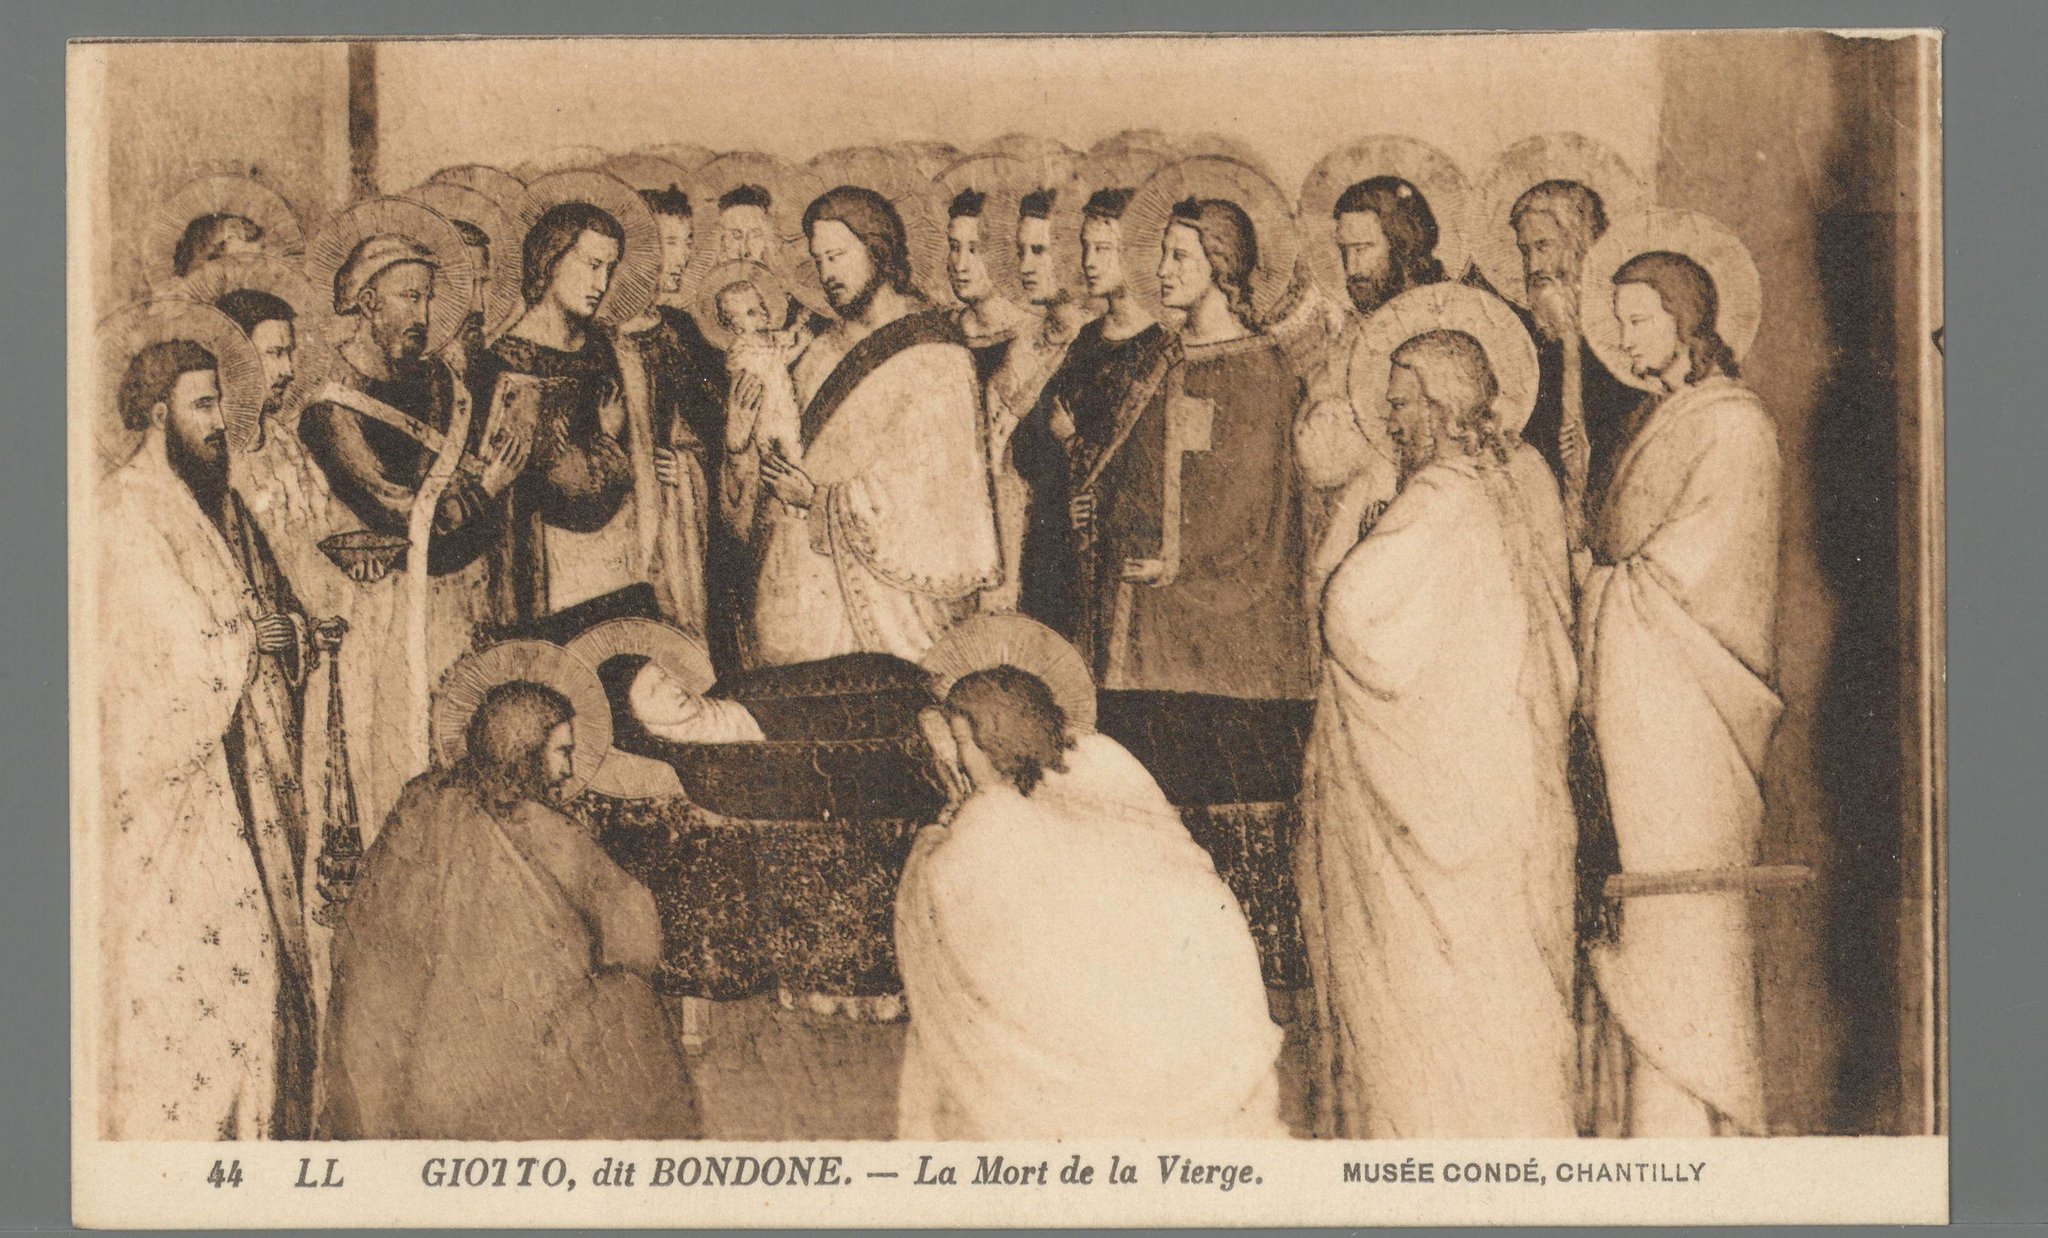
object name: photomechanical print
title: Giotto, dit Bondone - La Mort de la Vierge. Musée Condé, Chantilly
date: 1903-1932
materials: cardboard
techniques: photograph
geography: paris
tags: permanent exhibition, museum, picture, painting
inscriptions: collector's mark: ‘AFE v S’